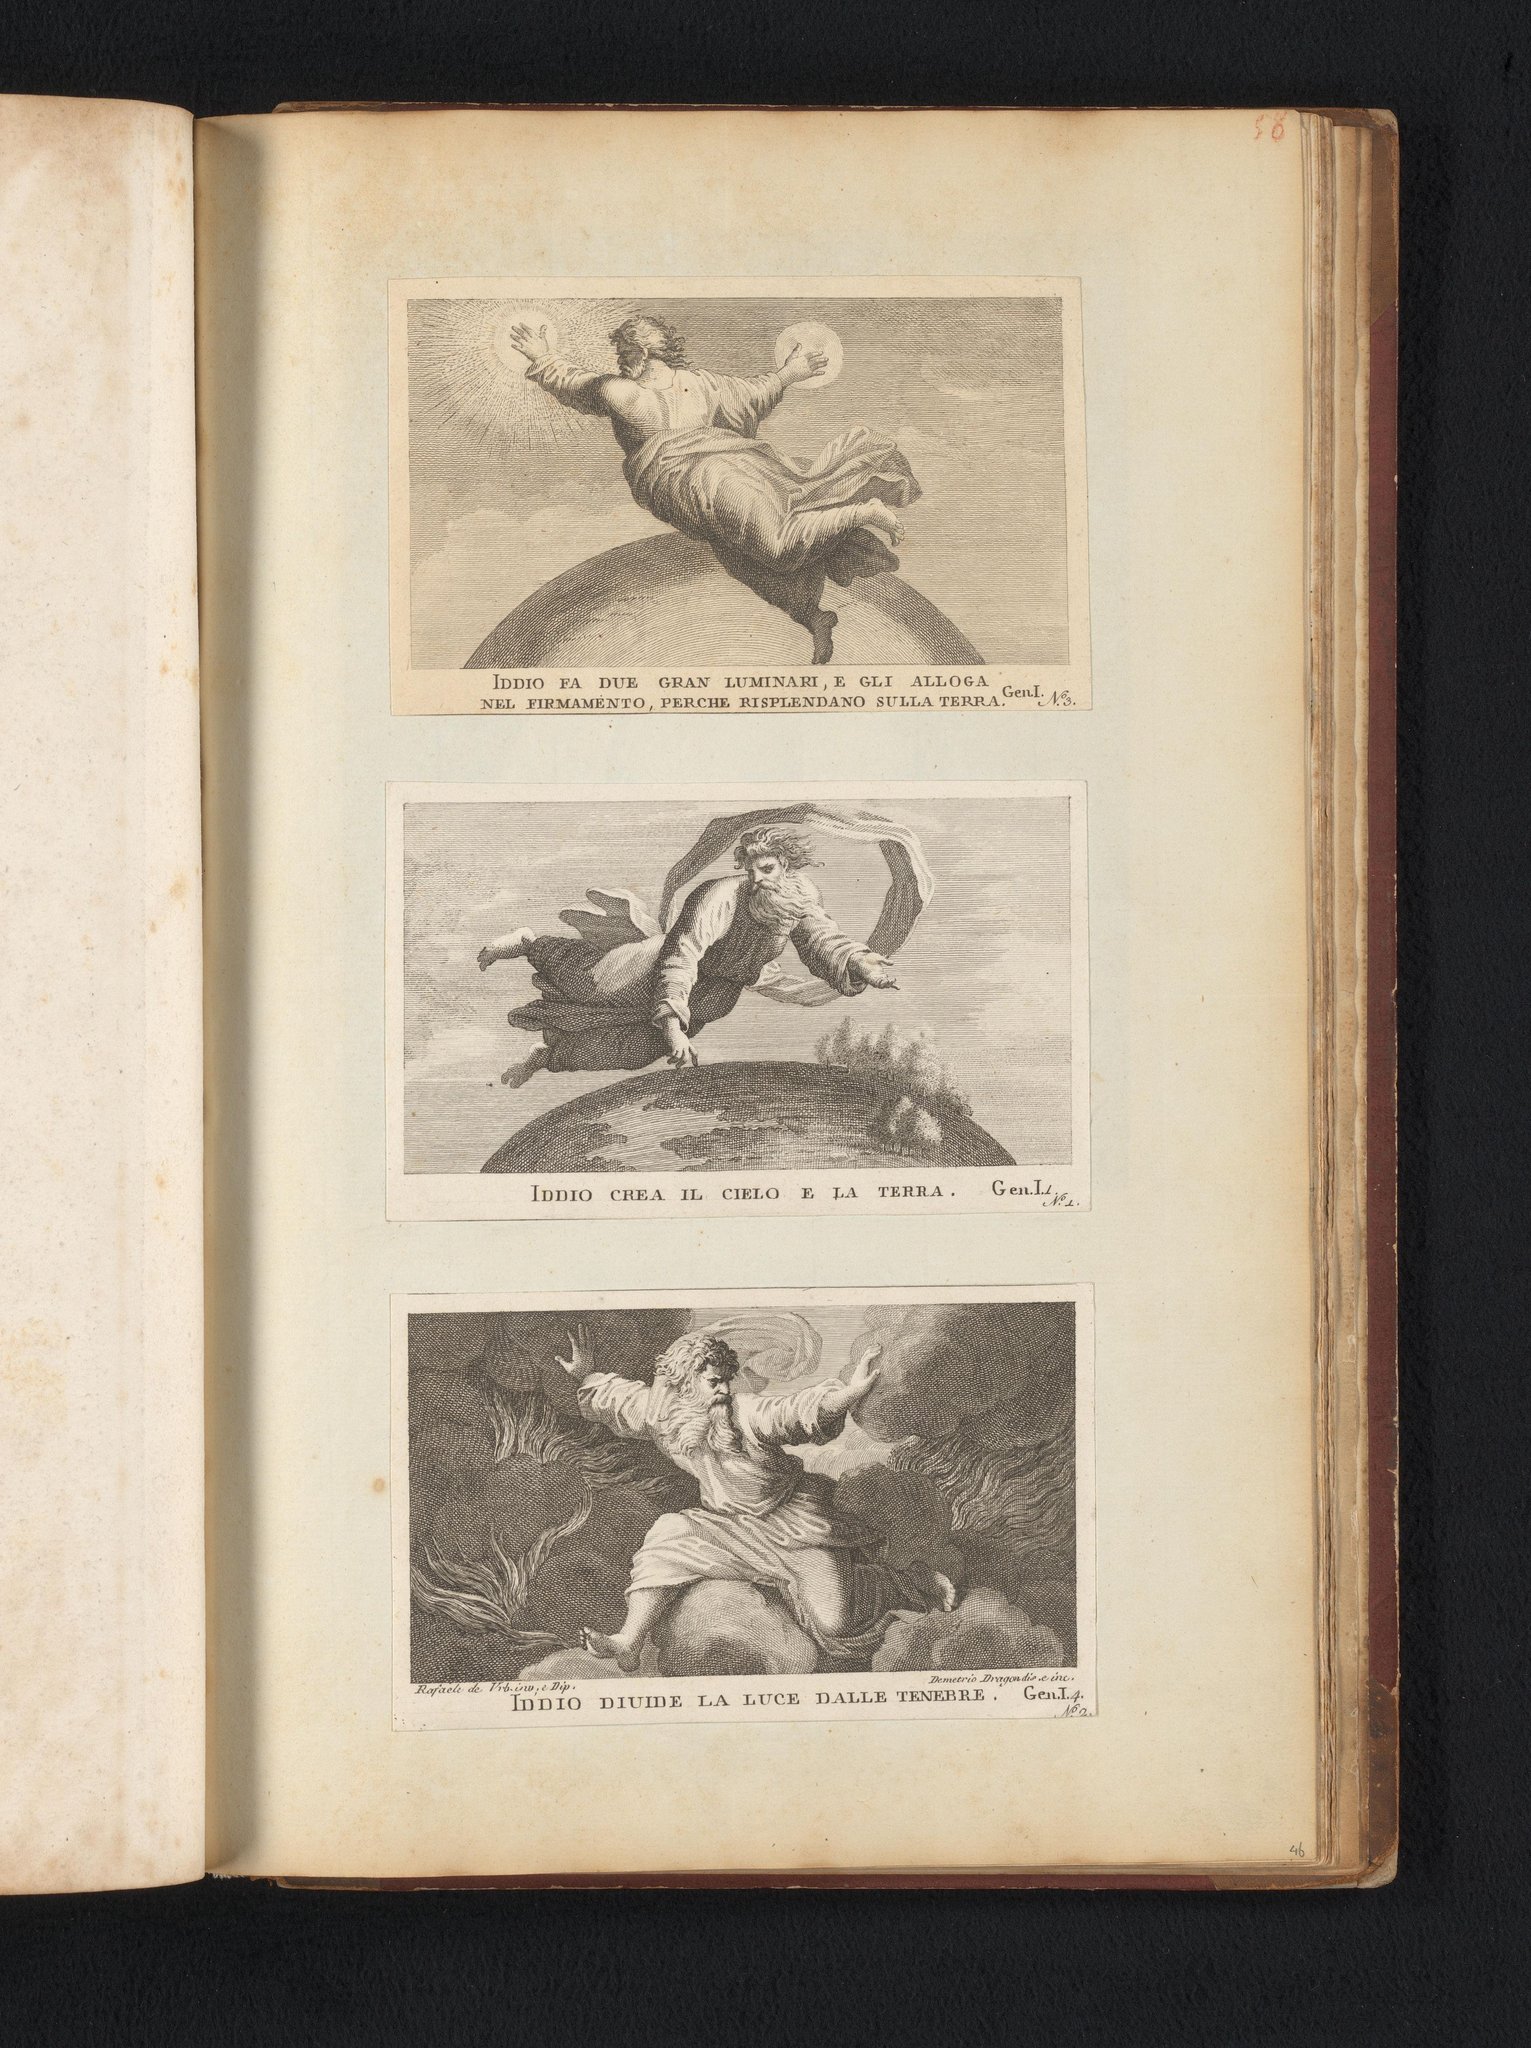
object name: album leaf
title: Scheppingsverhaal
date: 1750-1816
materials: paper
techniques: engraving, etching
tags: 'in the beginning ...' the ordering of chaos (genesis 1:1-2)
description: Drie ingeplakte prenten van onderdelen van scheppingsverhaal. Onderdeel van het tweede van twee albums met ingeplakte prenten en tekeningen te dienen als tekenvoorbeelden.